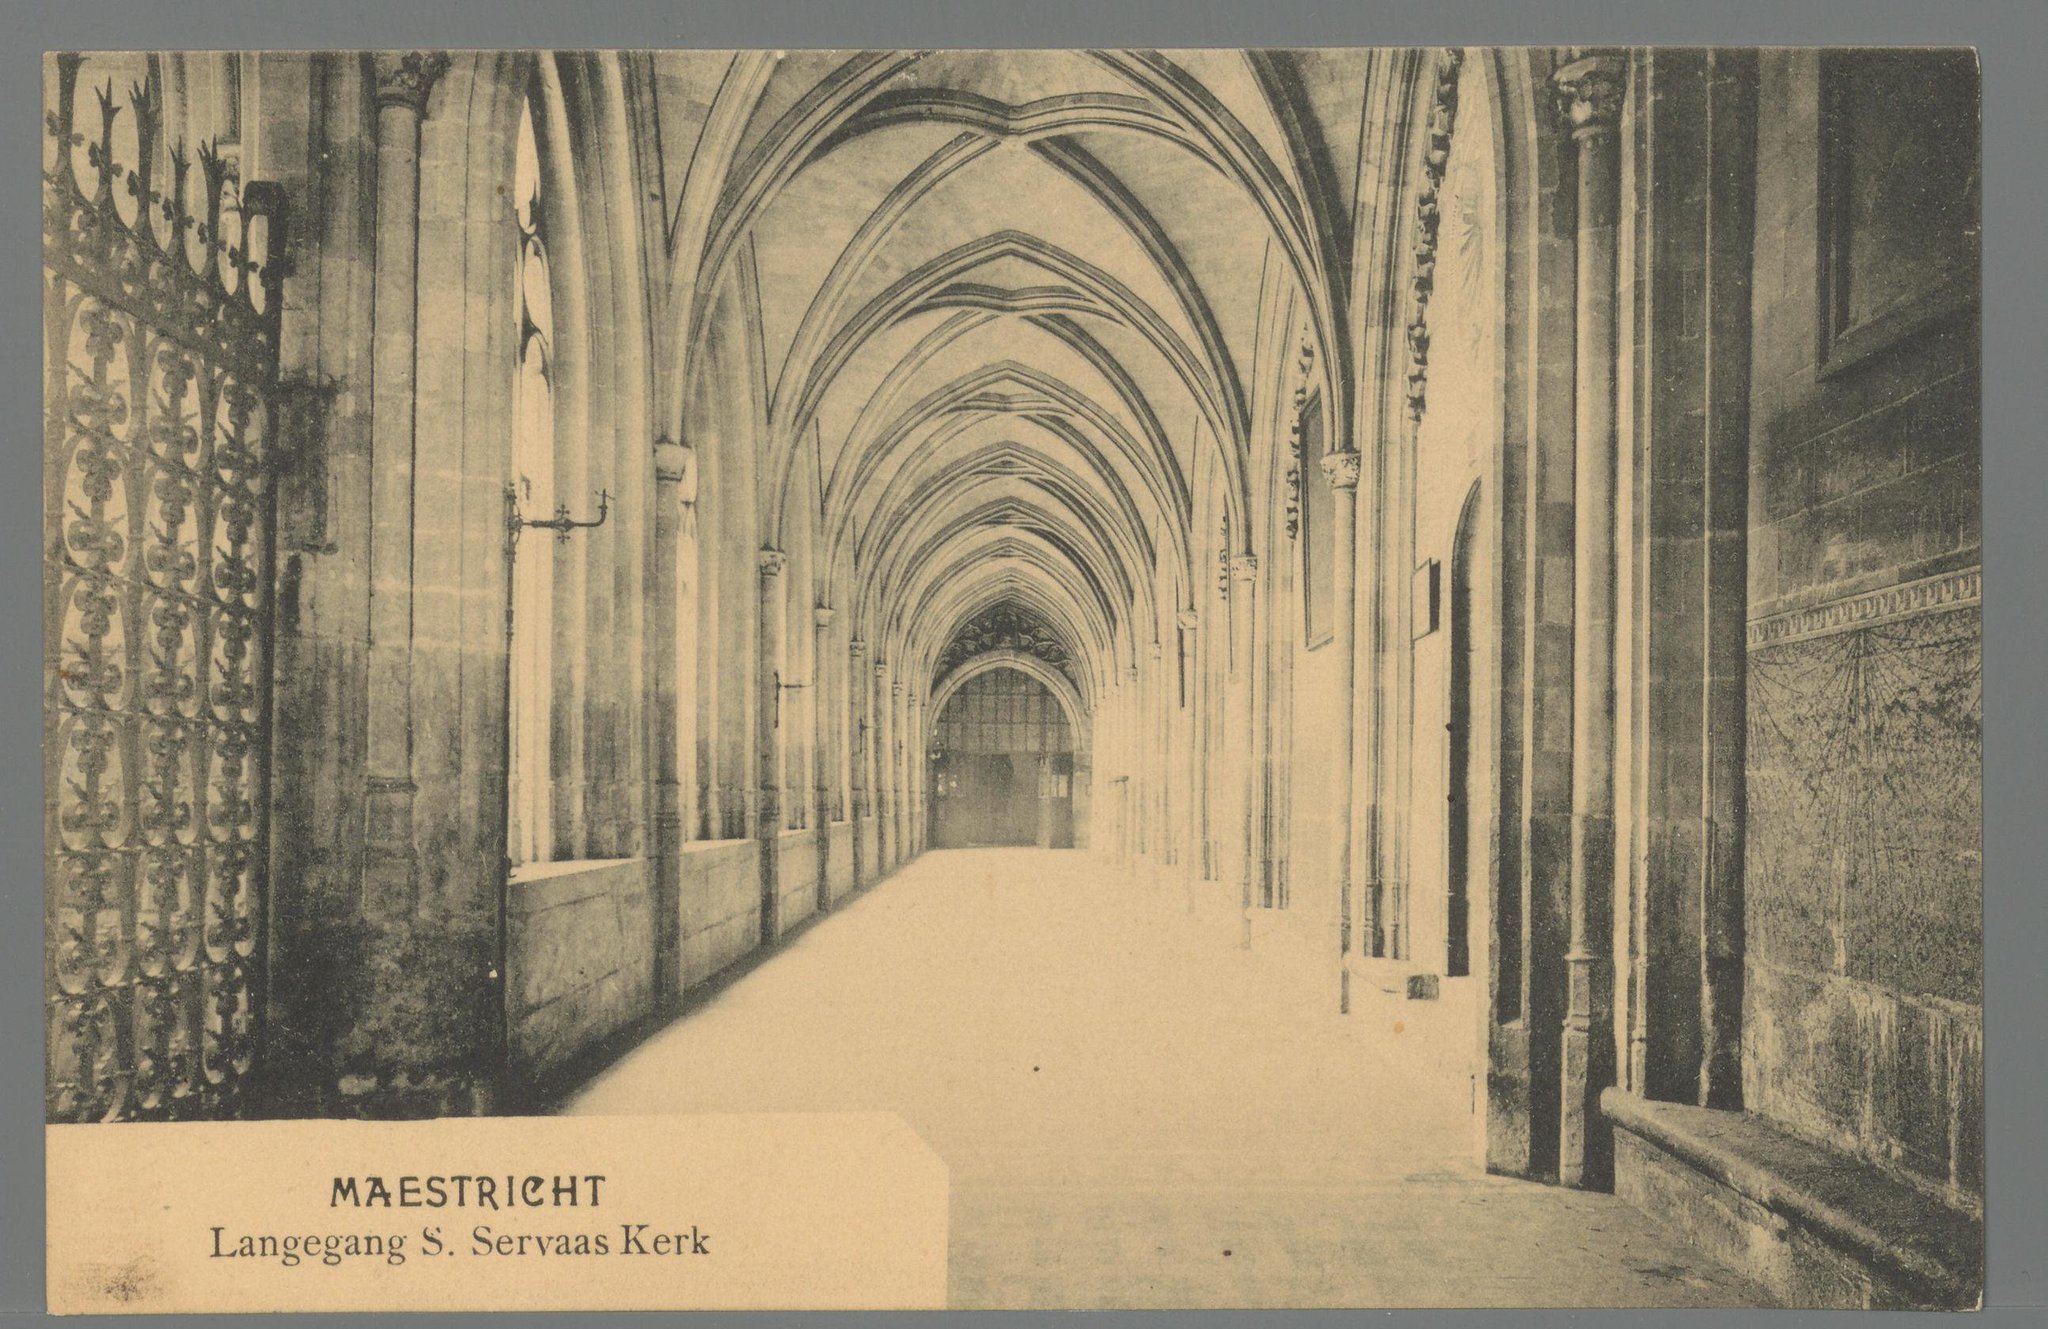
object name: photomechanical print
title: Maestricht. Langegang S. Servaas Kerk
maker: Anonymous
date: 1905-1930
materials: cardboard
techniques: photograph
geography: maastricht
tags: interior of church, gallery (spacious corridor)